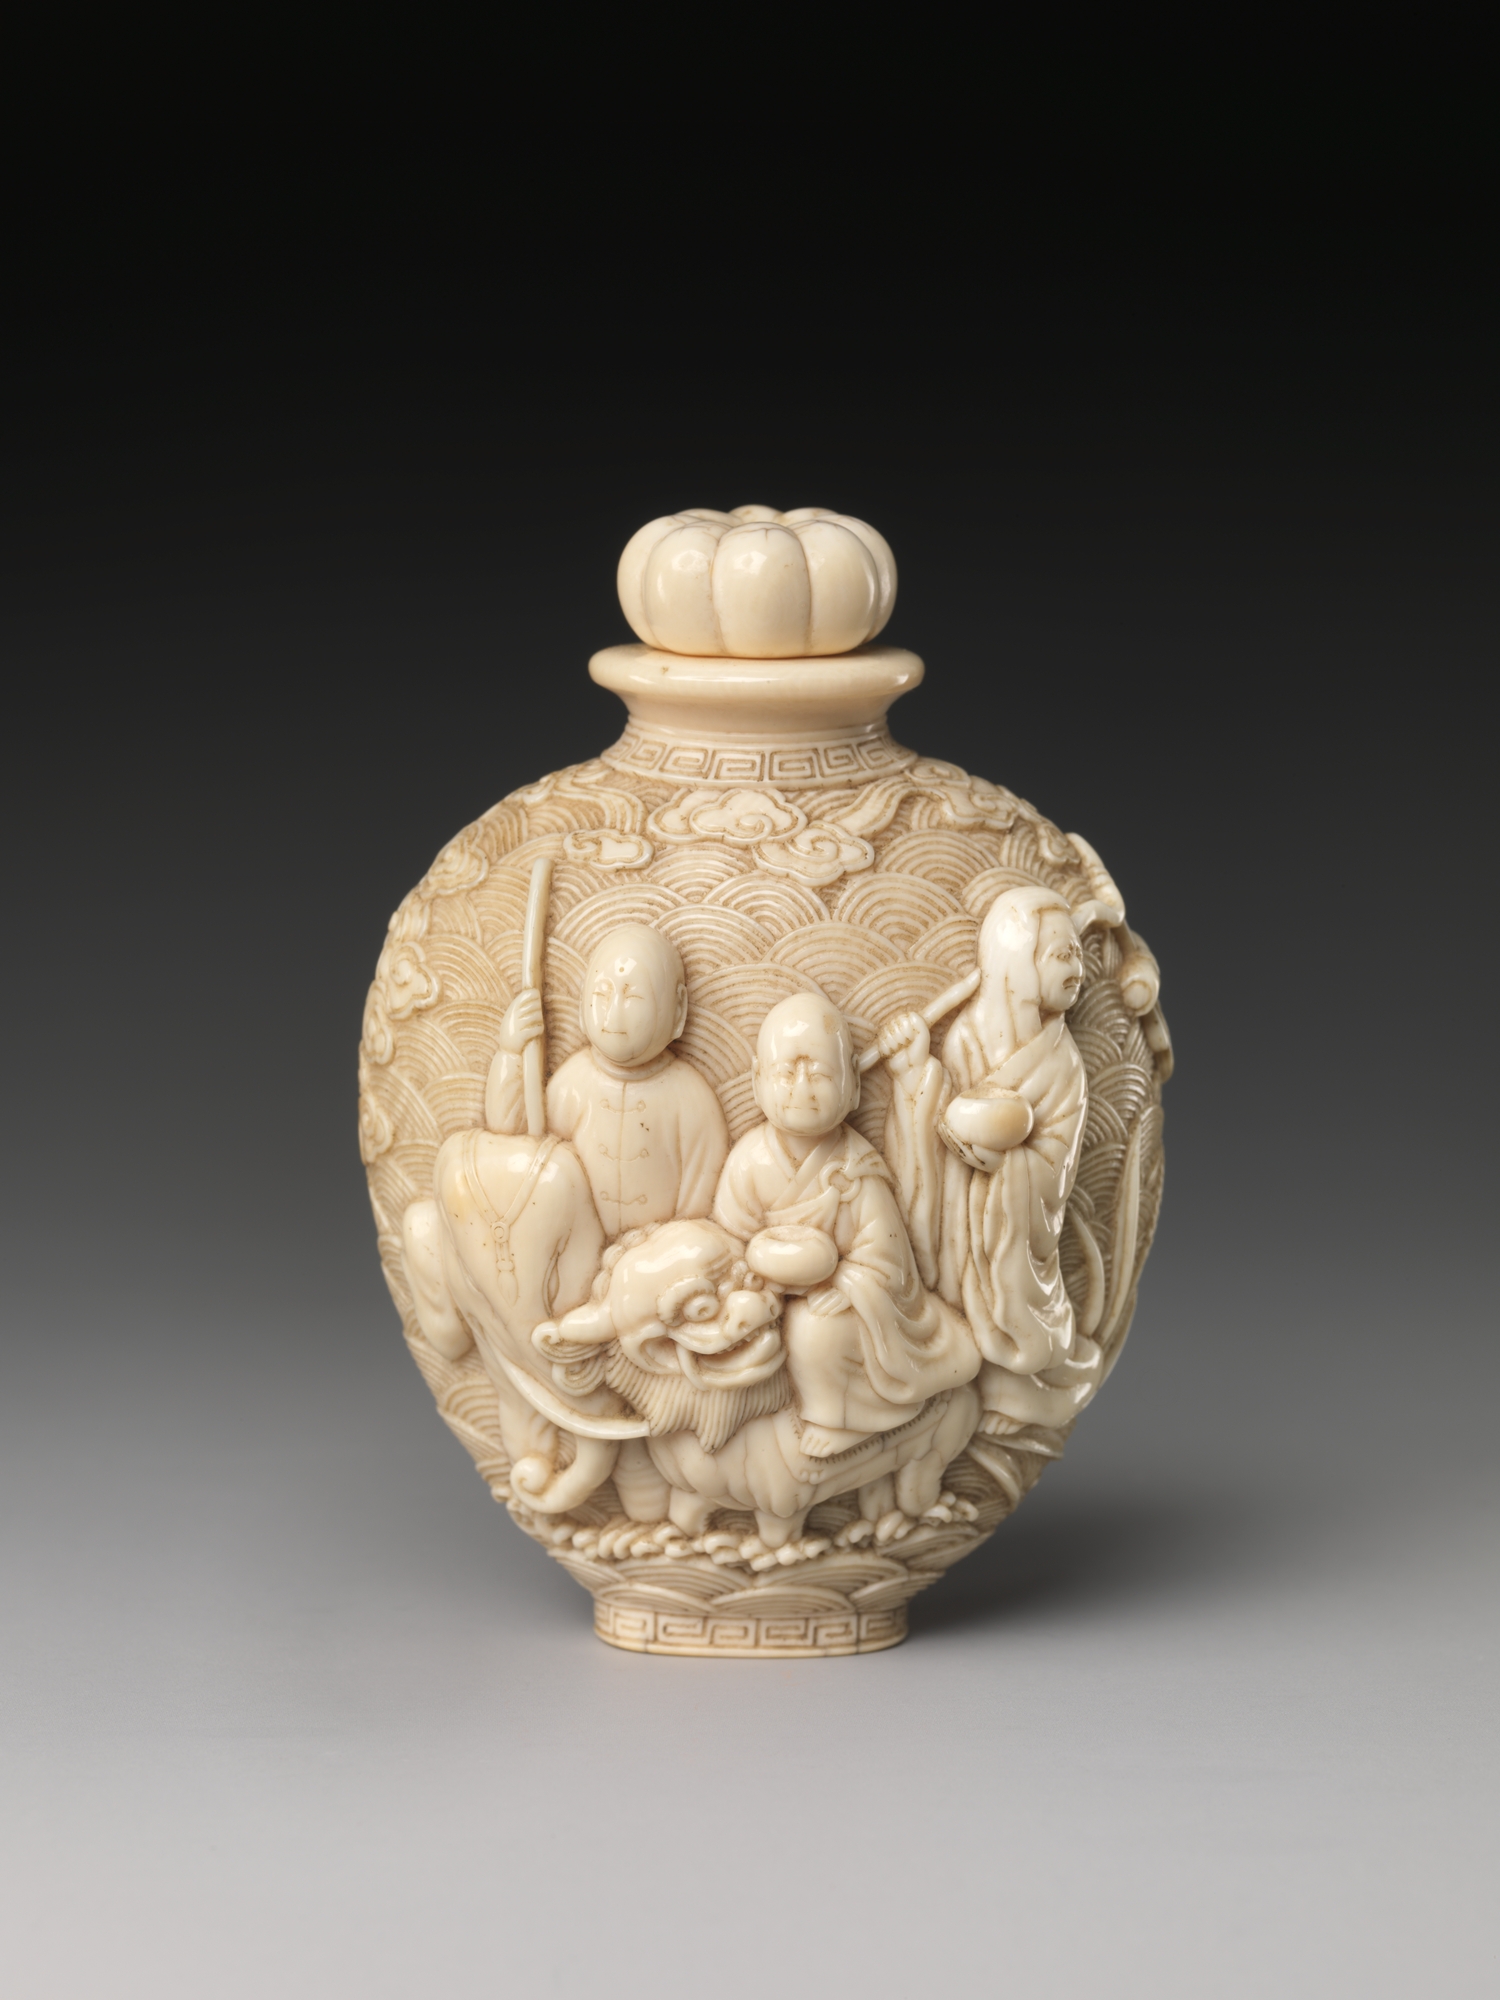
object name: snuff bottle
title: Snuff Bottle with Buddhist Figures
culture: chinese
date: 1701-1800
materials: ivory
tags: human figures,animals,buddhism